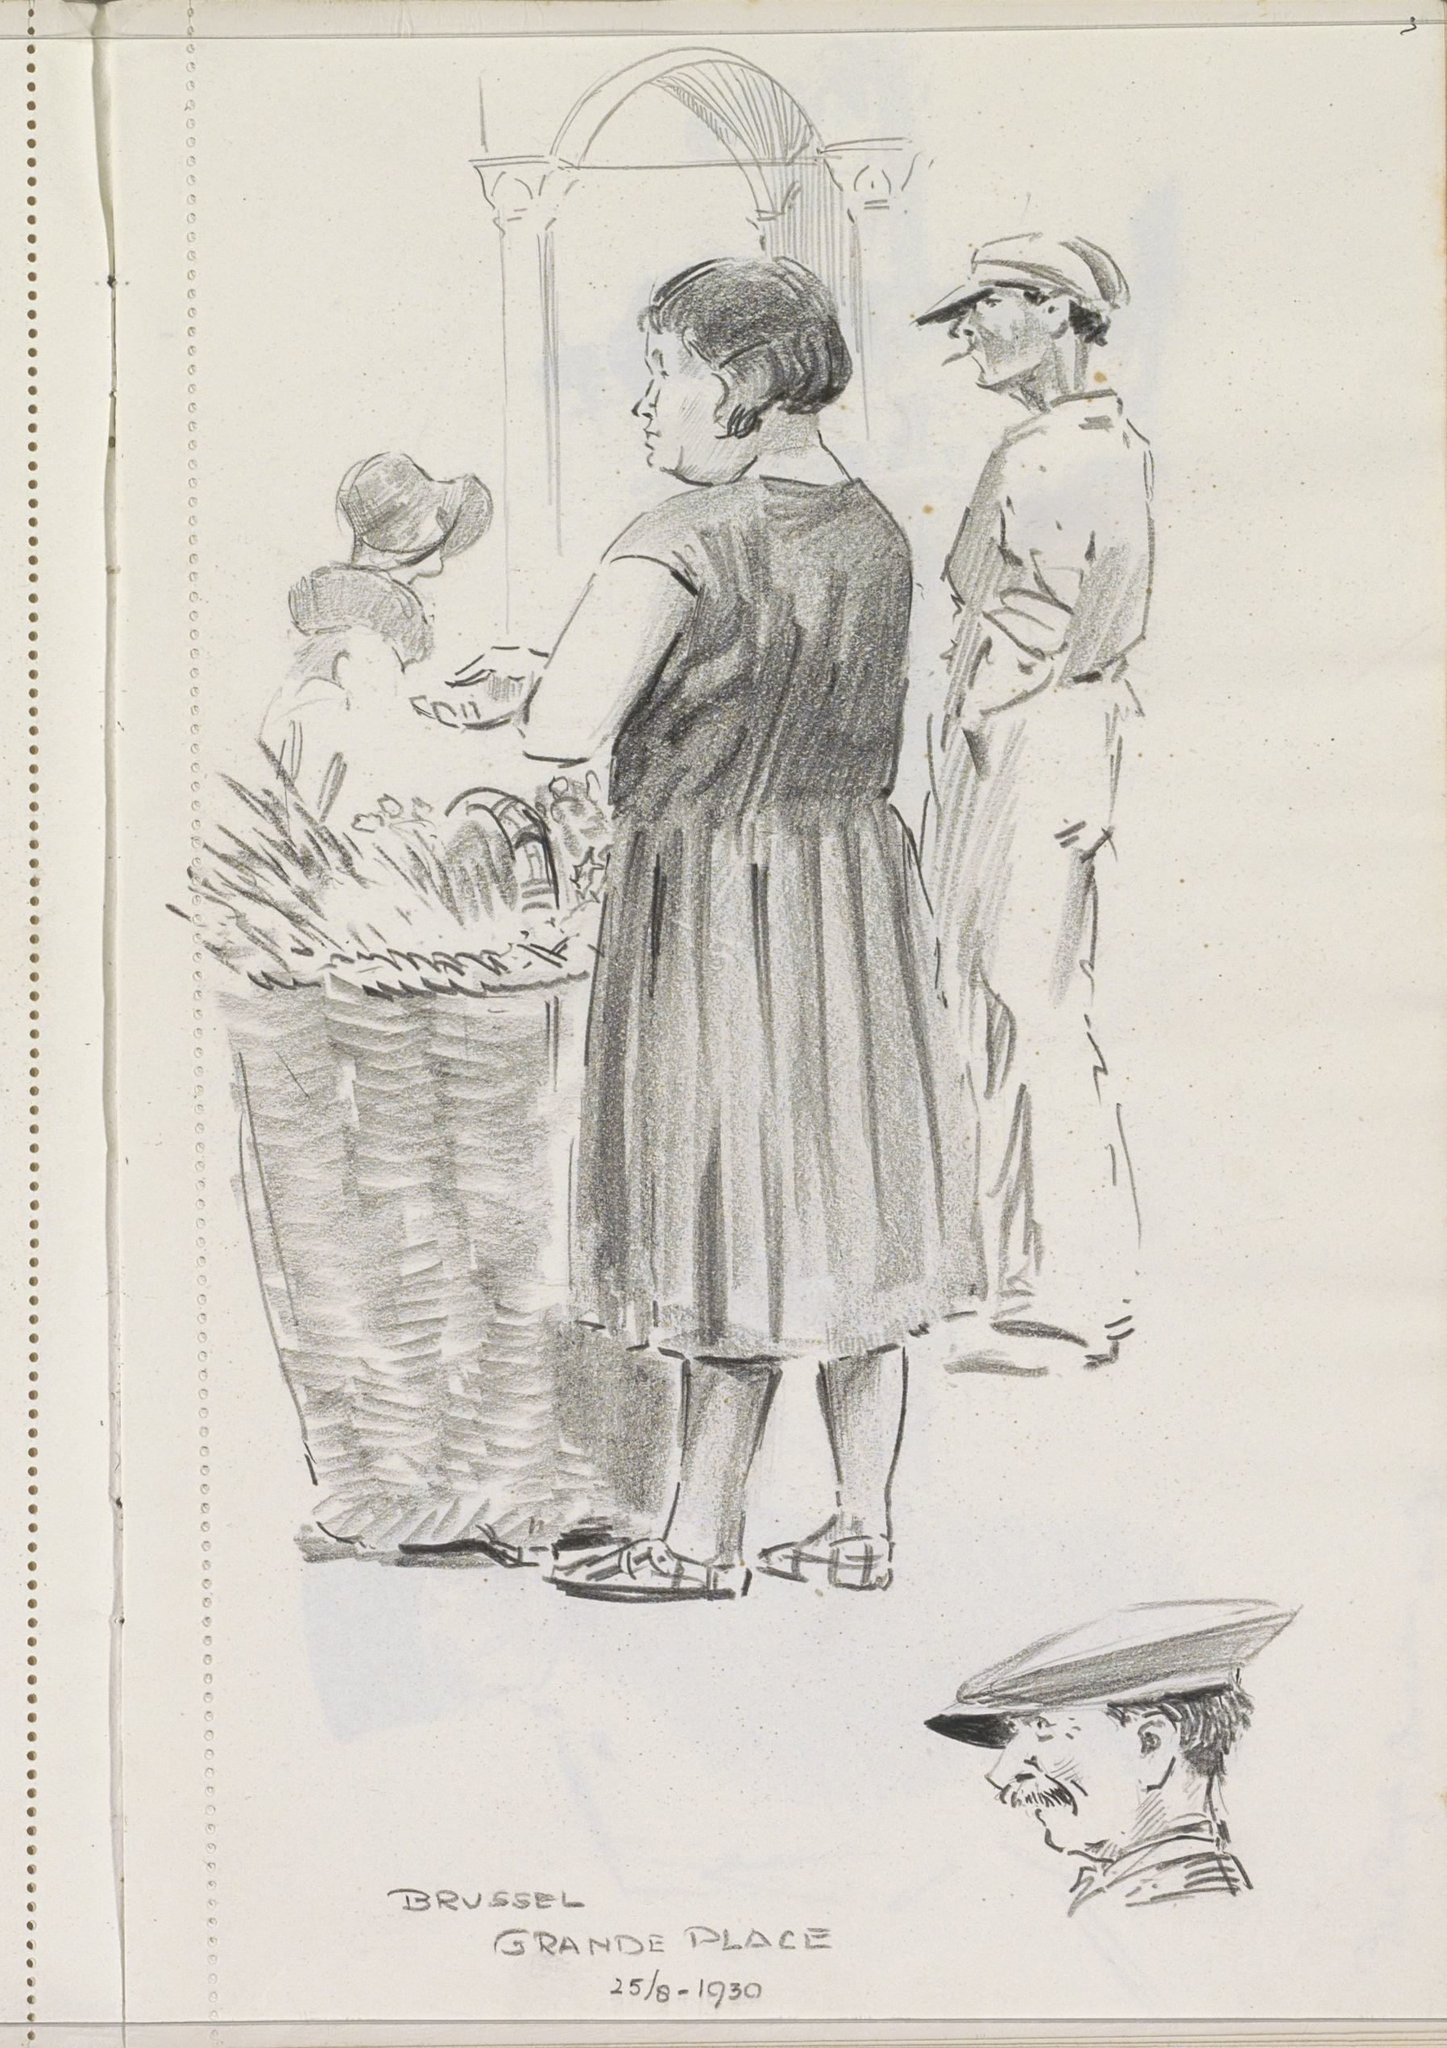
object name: sketchbook leaf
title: Figuren op de bloemen- en plantenmarkt te Brussel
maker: otto verhagen (i)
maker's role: draughtsman, print maker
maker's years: 1885-1951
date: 1908-1930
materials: chalk, paper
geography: brussels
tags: city dwellers, market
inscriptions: date and inscription: ‘BRUSSEL/ GRANDE PLACE/ 25/8/1930’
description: Tevens een studie van een man met een pet. Pagina 3 uit een schetsboek met 60 bladen.